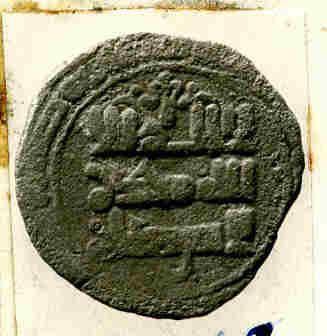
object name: coin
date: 998-1030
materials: copper, silver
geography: iran